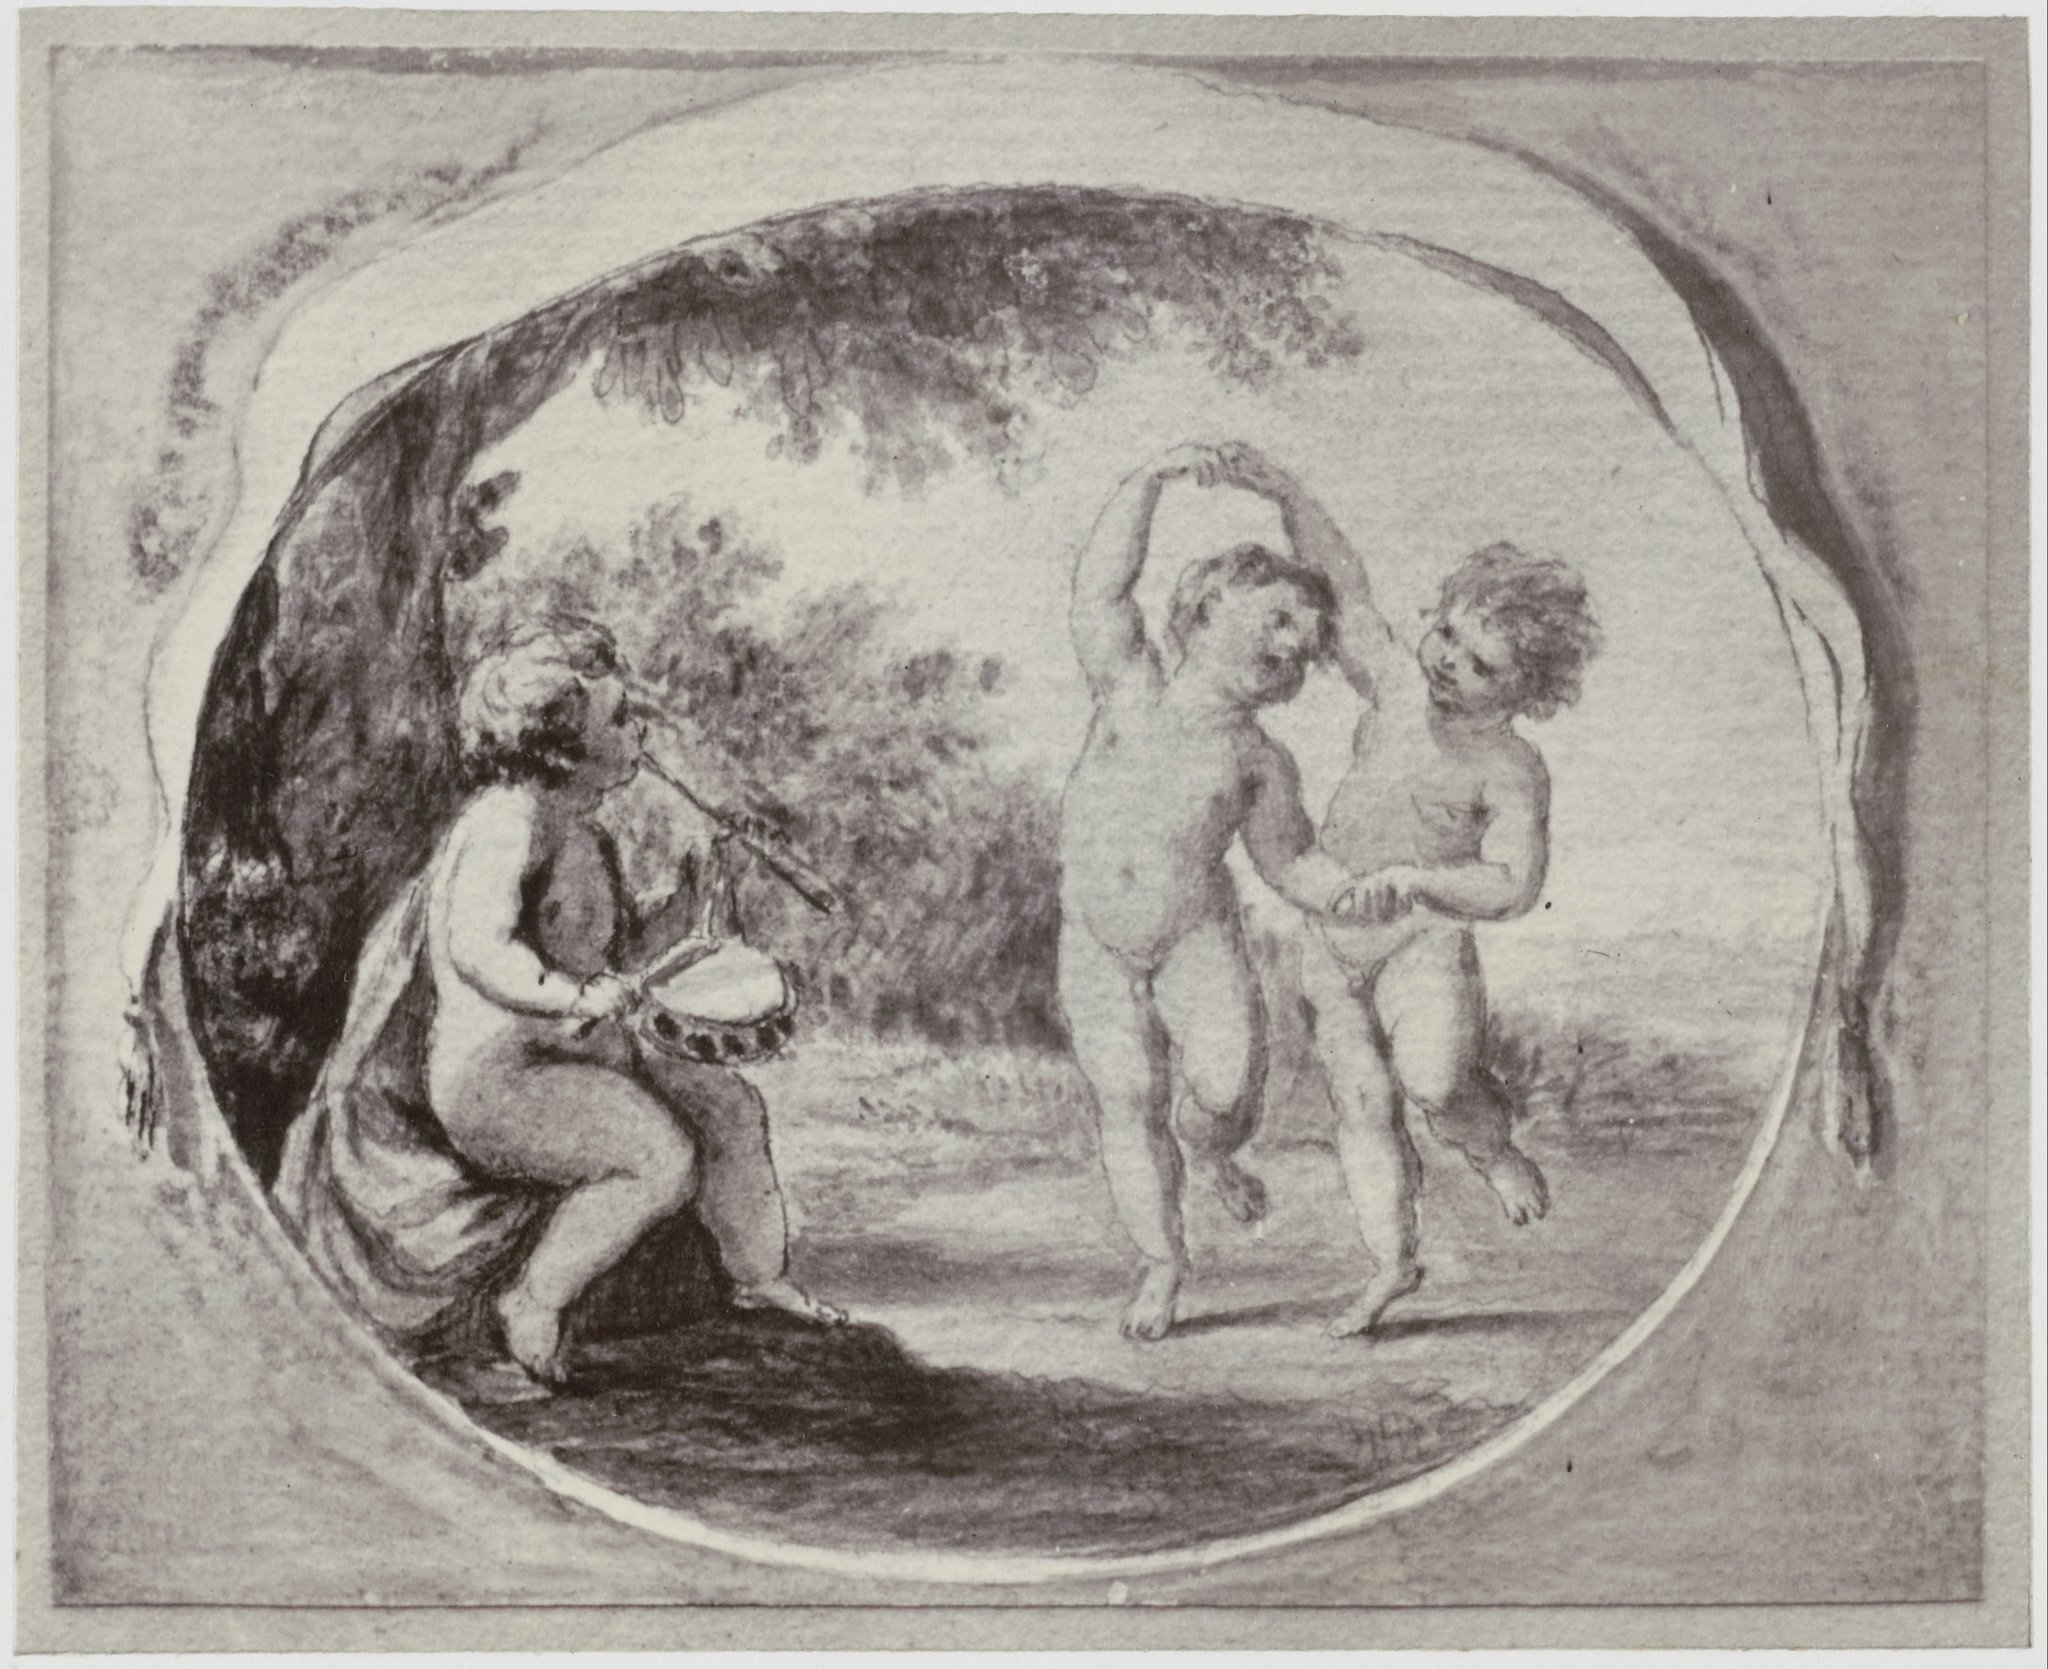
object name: photograph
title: Cipriani, A Card for a Ball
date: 1855-1858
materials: cardboard, paper, photographic support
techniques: albumen print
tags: drawing, sketch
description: Fotoreproductie van tekening in 'The Reveley Collection of Drawings at Brynygwin', afb. 56.